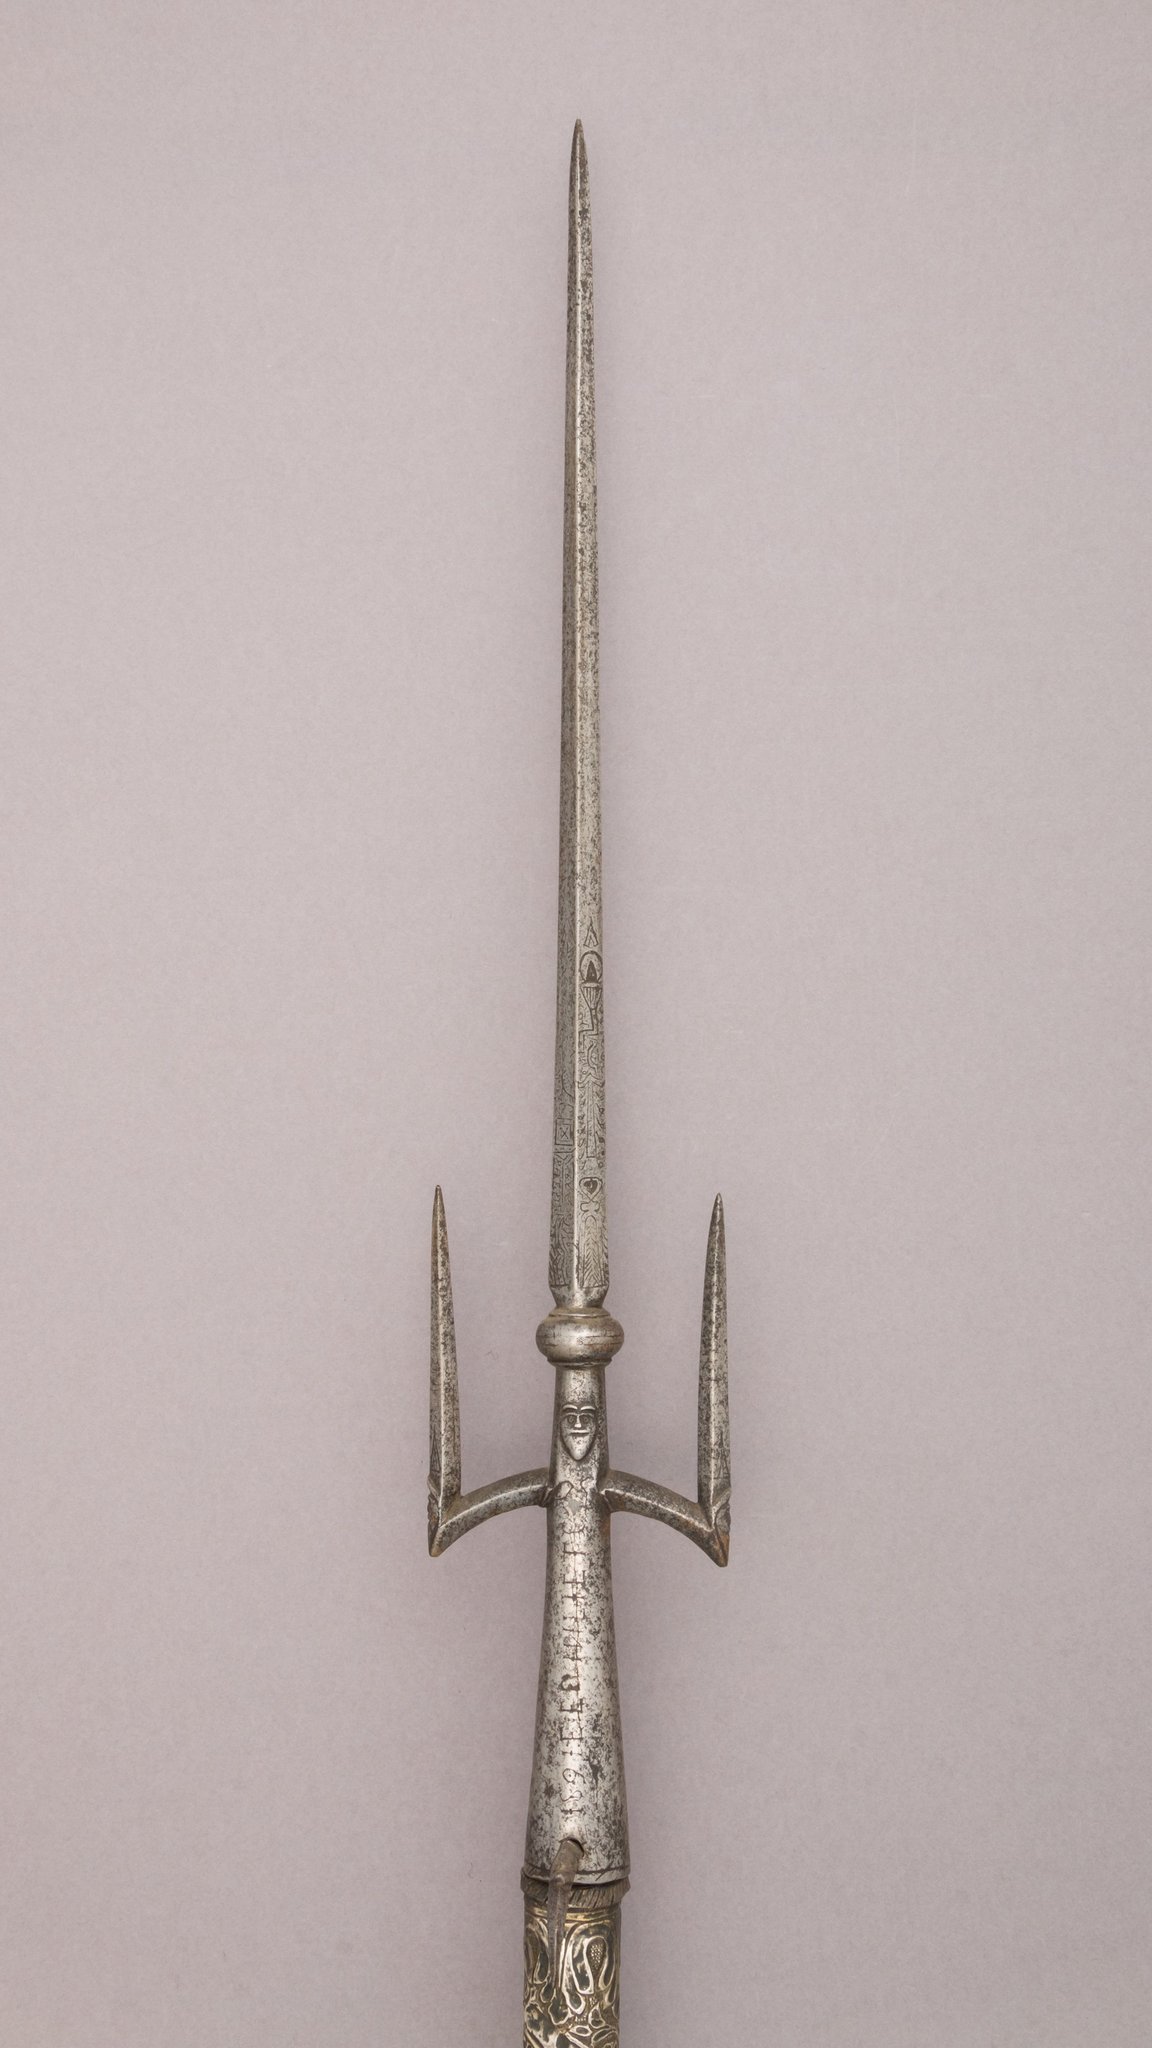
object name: military fork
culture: french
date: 1567-1600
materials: silver, steel, wood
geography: france